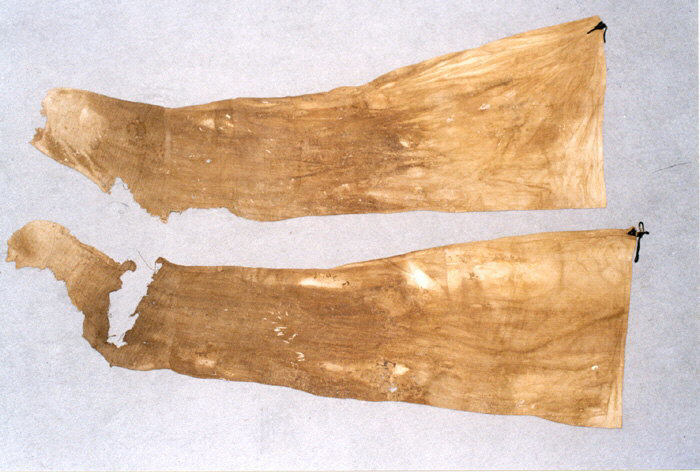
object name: legging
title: Pair of leggings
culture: alanic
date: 601-900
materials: cotton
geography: caucasus